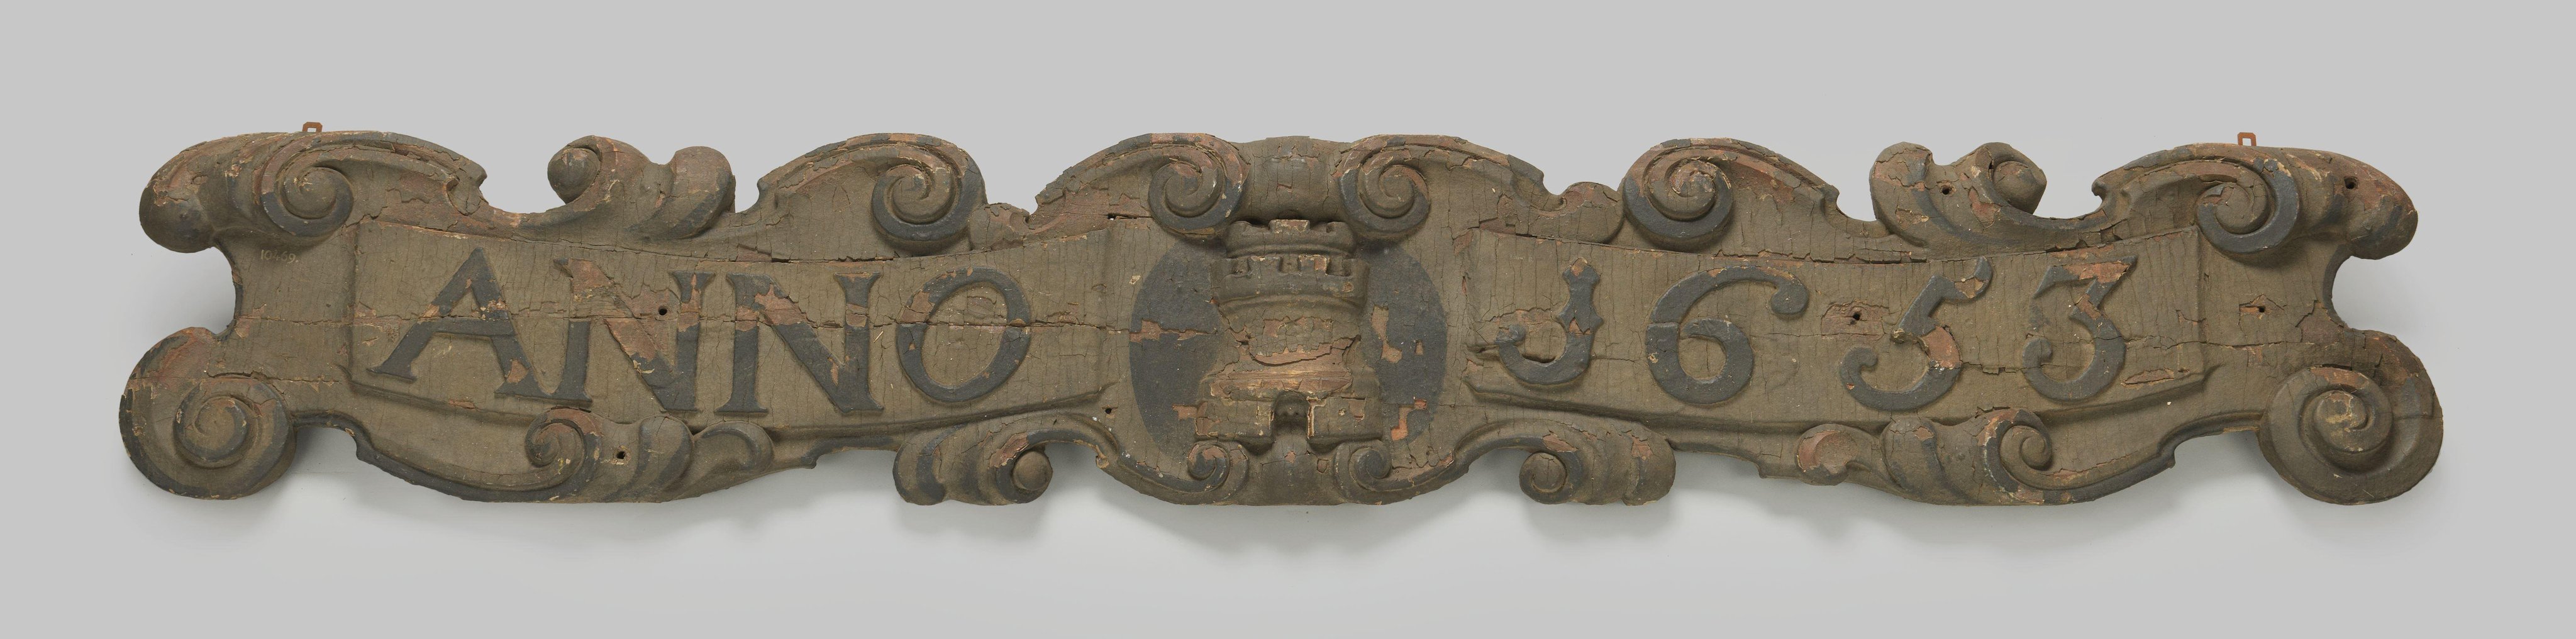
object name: cartouche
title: Gesneden en beschilderde cartouche van grenenhout met het wapen van Middelburg.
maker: Anonymous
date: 1653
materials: paint, wood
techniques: cutting, painting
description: Gesneden en beschilderd cartouche van grenenhout met het wapen van Middelburg in het midden en rechts en links een banderol waarop Anno 1653. Grijs geverfd.